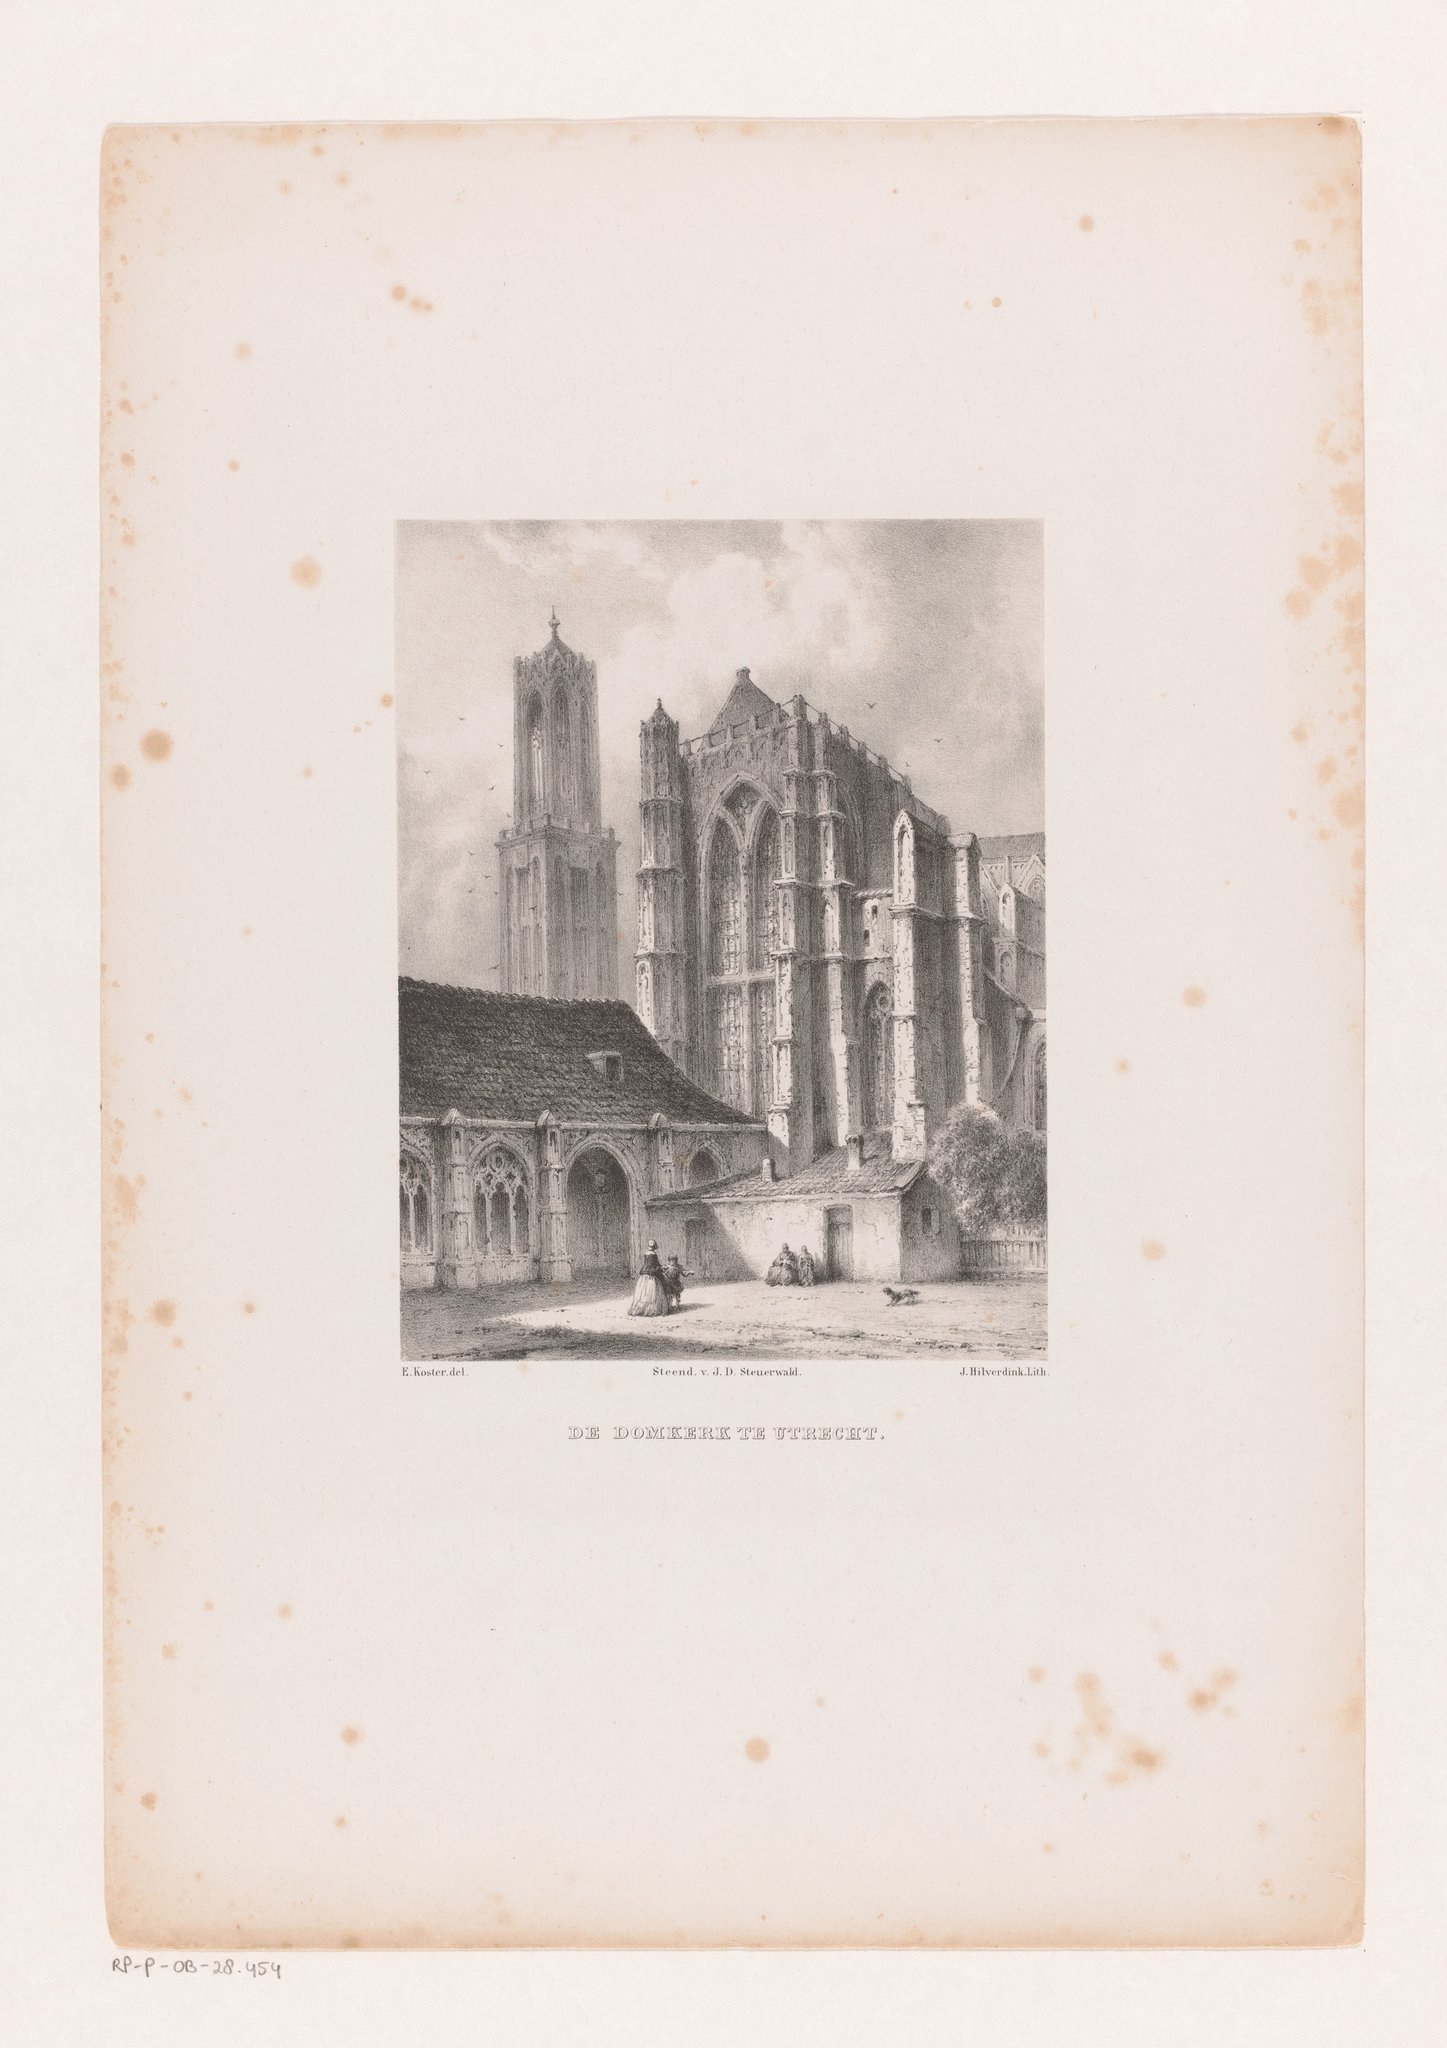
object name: print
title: Domkerk en Domtoren in Utrecht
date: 1858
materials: paper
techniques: lithograph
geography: amsterdam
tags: church (exterior), parts of church exterior and annexes: tower, utrecht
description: Deze prent komt uit: Koster, E. 'E. Koster's schetsboek: Nederlandsche Stads- en Havengezichten, uitgegeven onder medewerking van de maatschappij Arti et Amicitiae, Amsterdam, F. Buffa en Zn., e.a.' Amsterdam 1858.